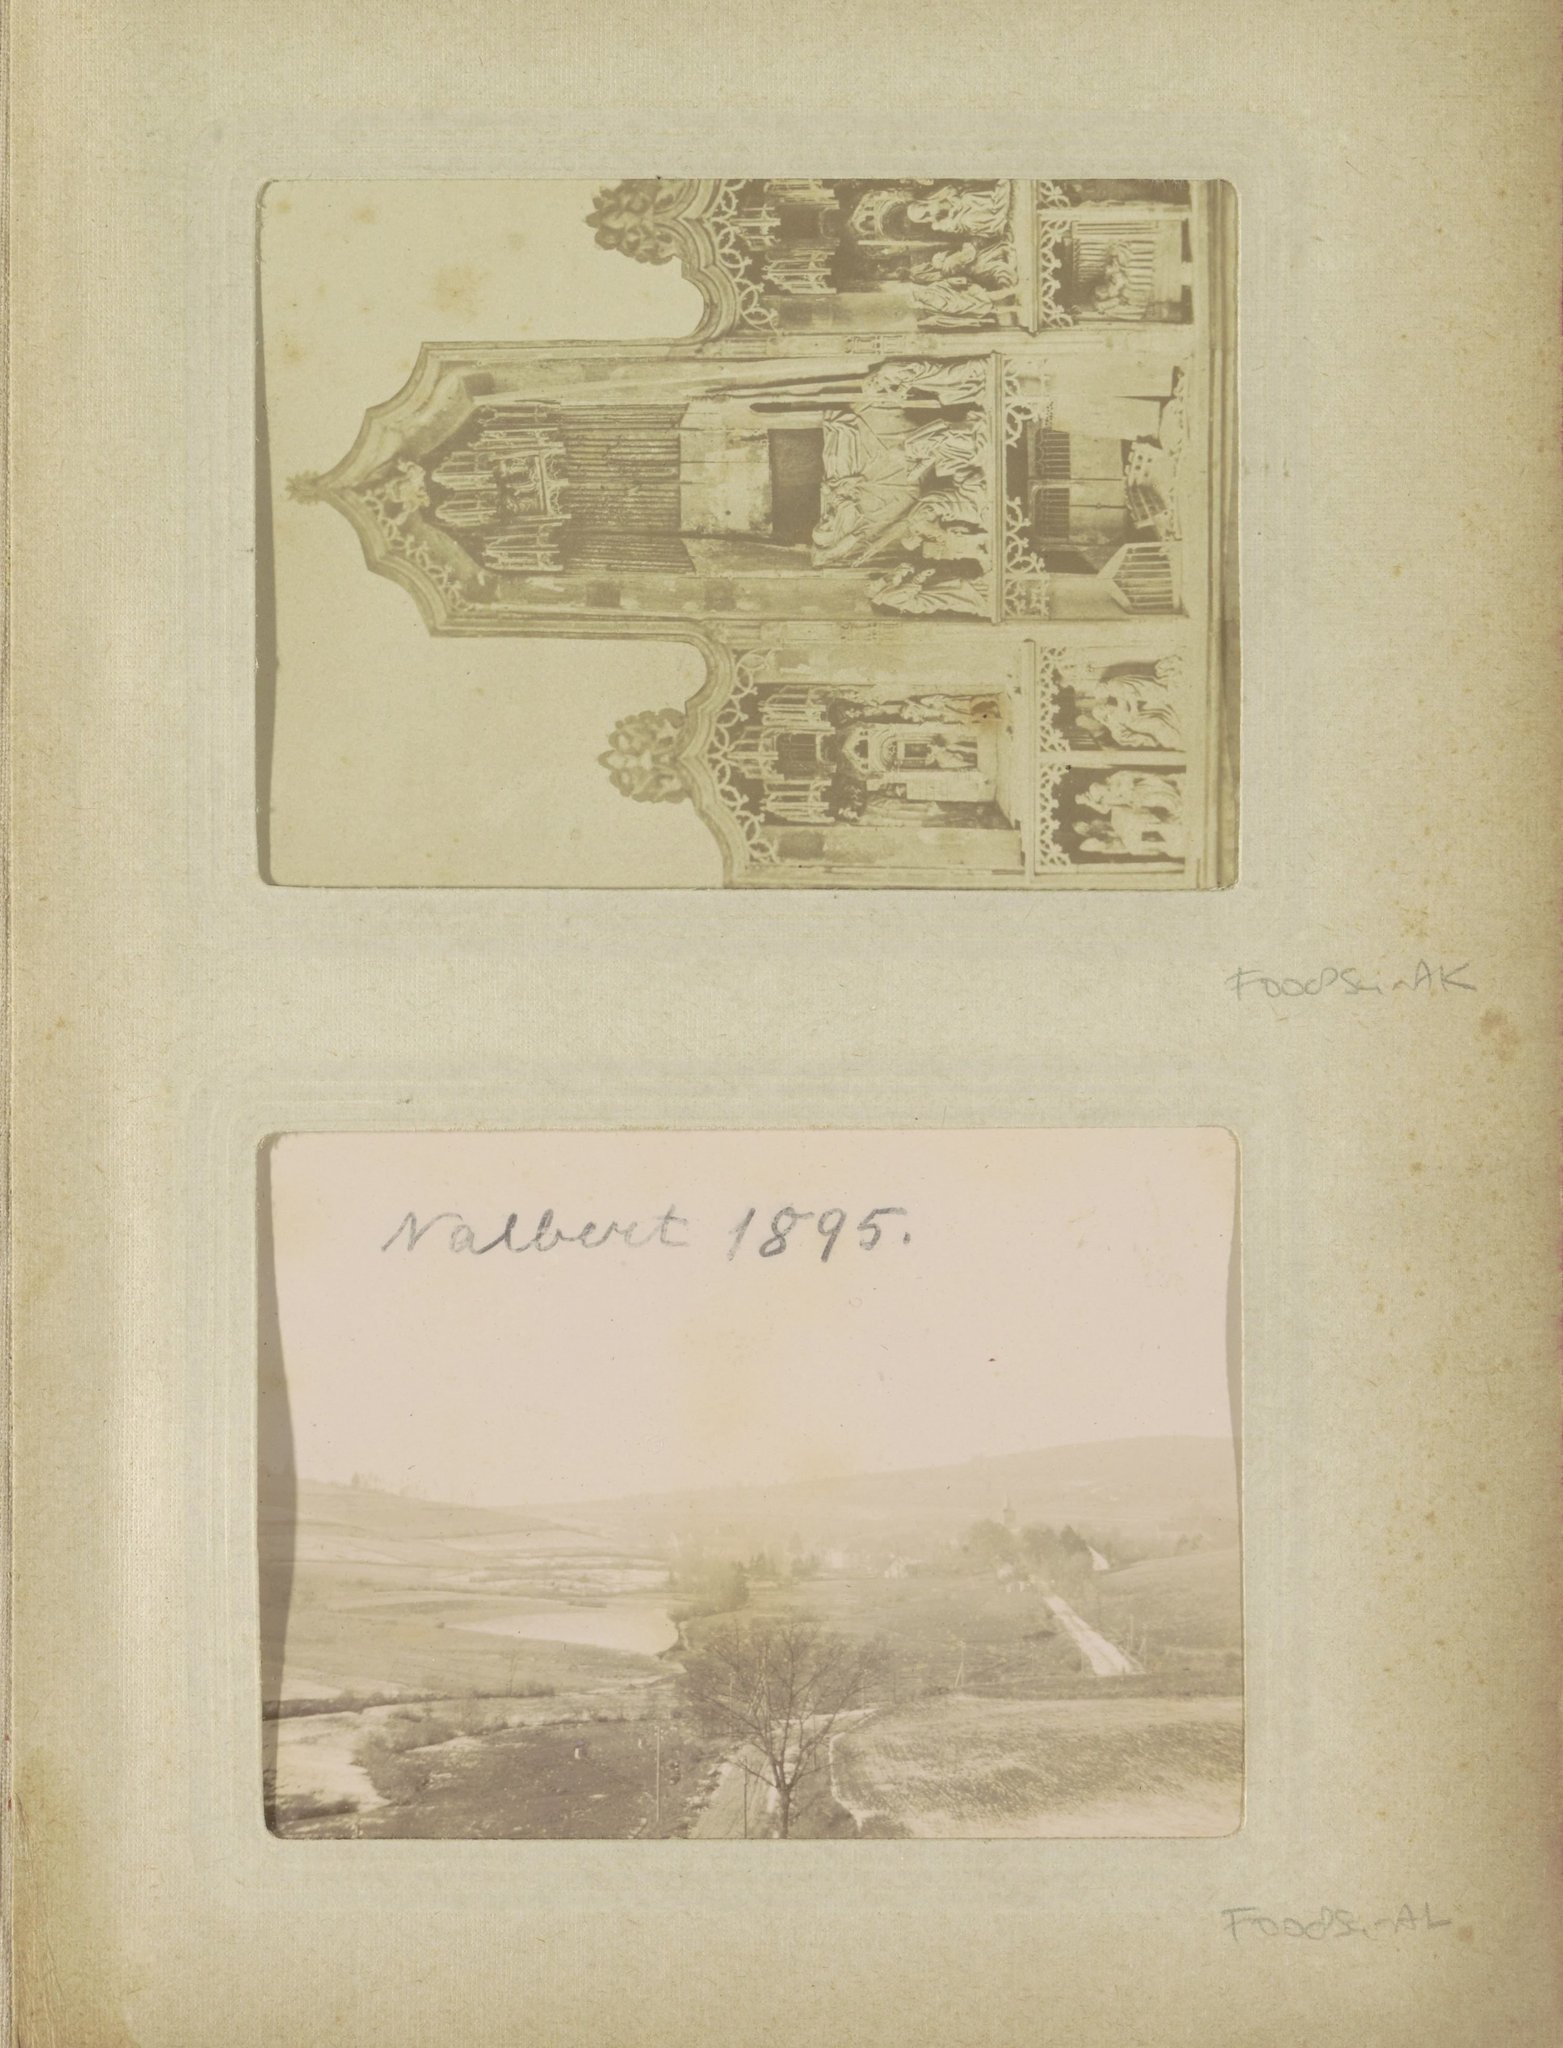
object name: cabinet photograph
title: Altaarretabel in een kerk in Valbert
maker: Anonymous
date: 1890-1910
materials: cardboard, paper, photographic support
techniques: albumen print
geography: valbert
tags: altar with altar-piece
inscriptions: inscription: ‘Alter Altar Valbert’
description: Onderdeel van Fotoalbum van Carl Heinrich Fliegenschmidt, gevangenisdirecteur te Oslebshausen.